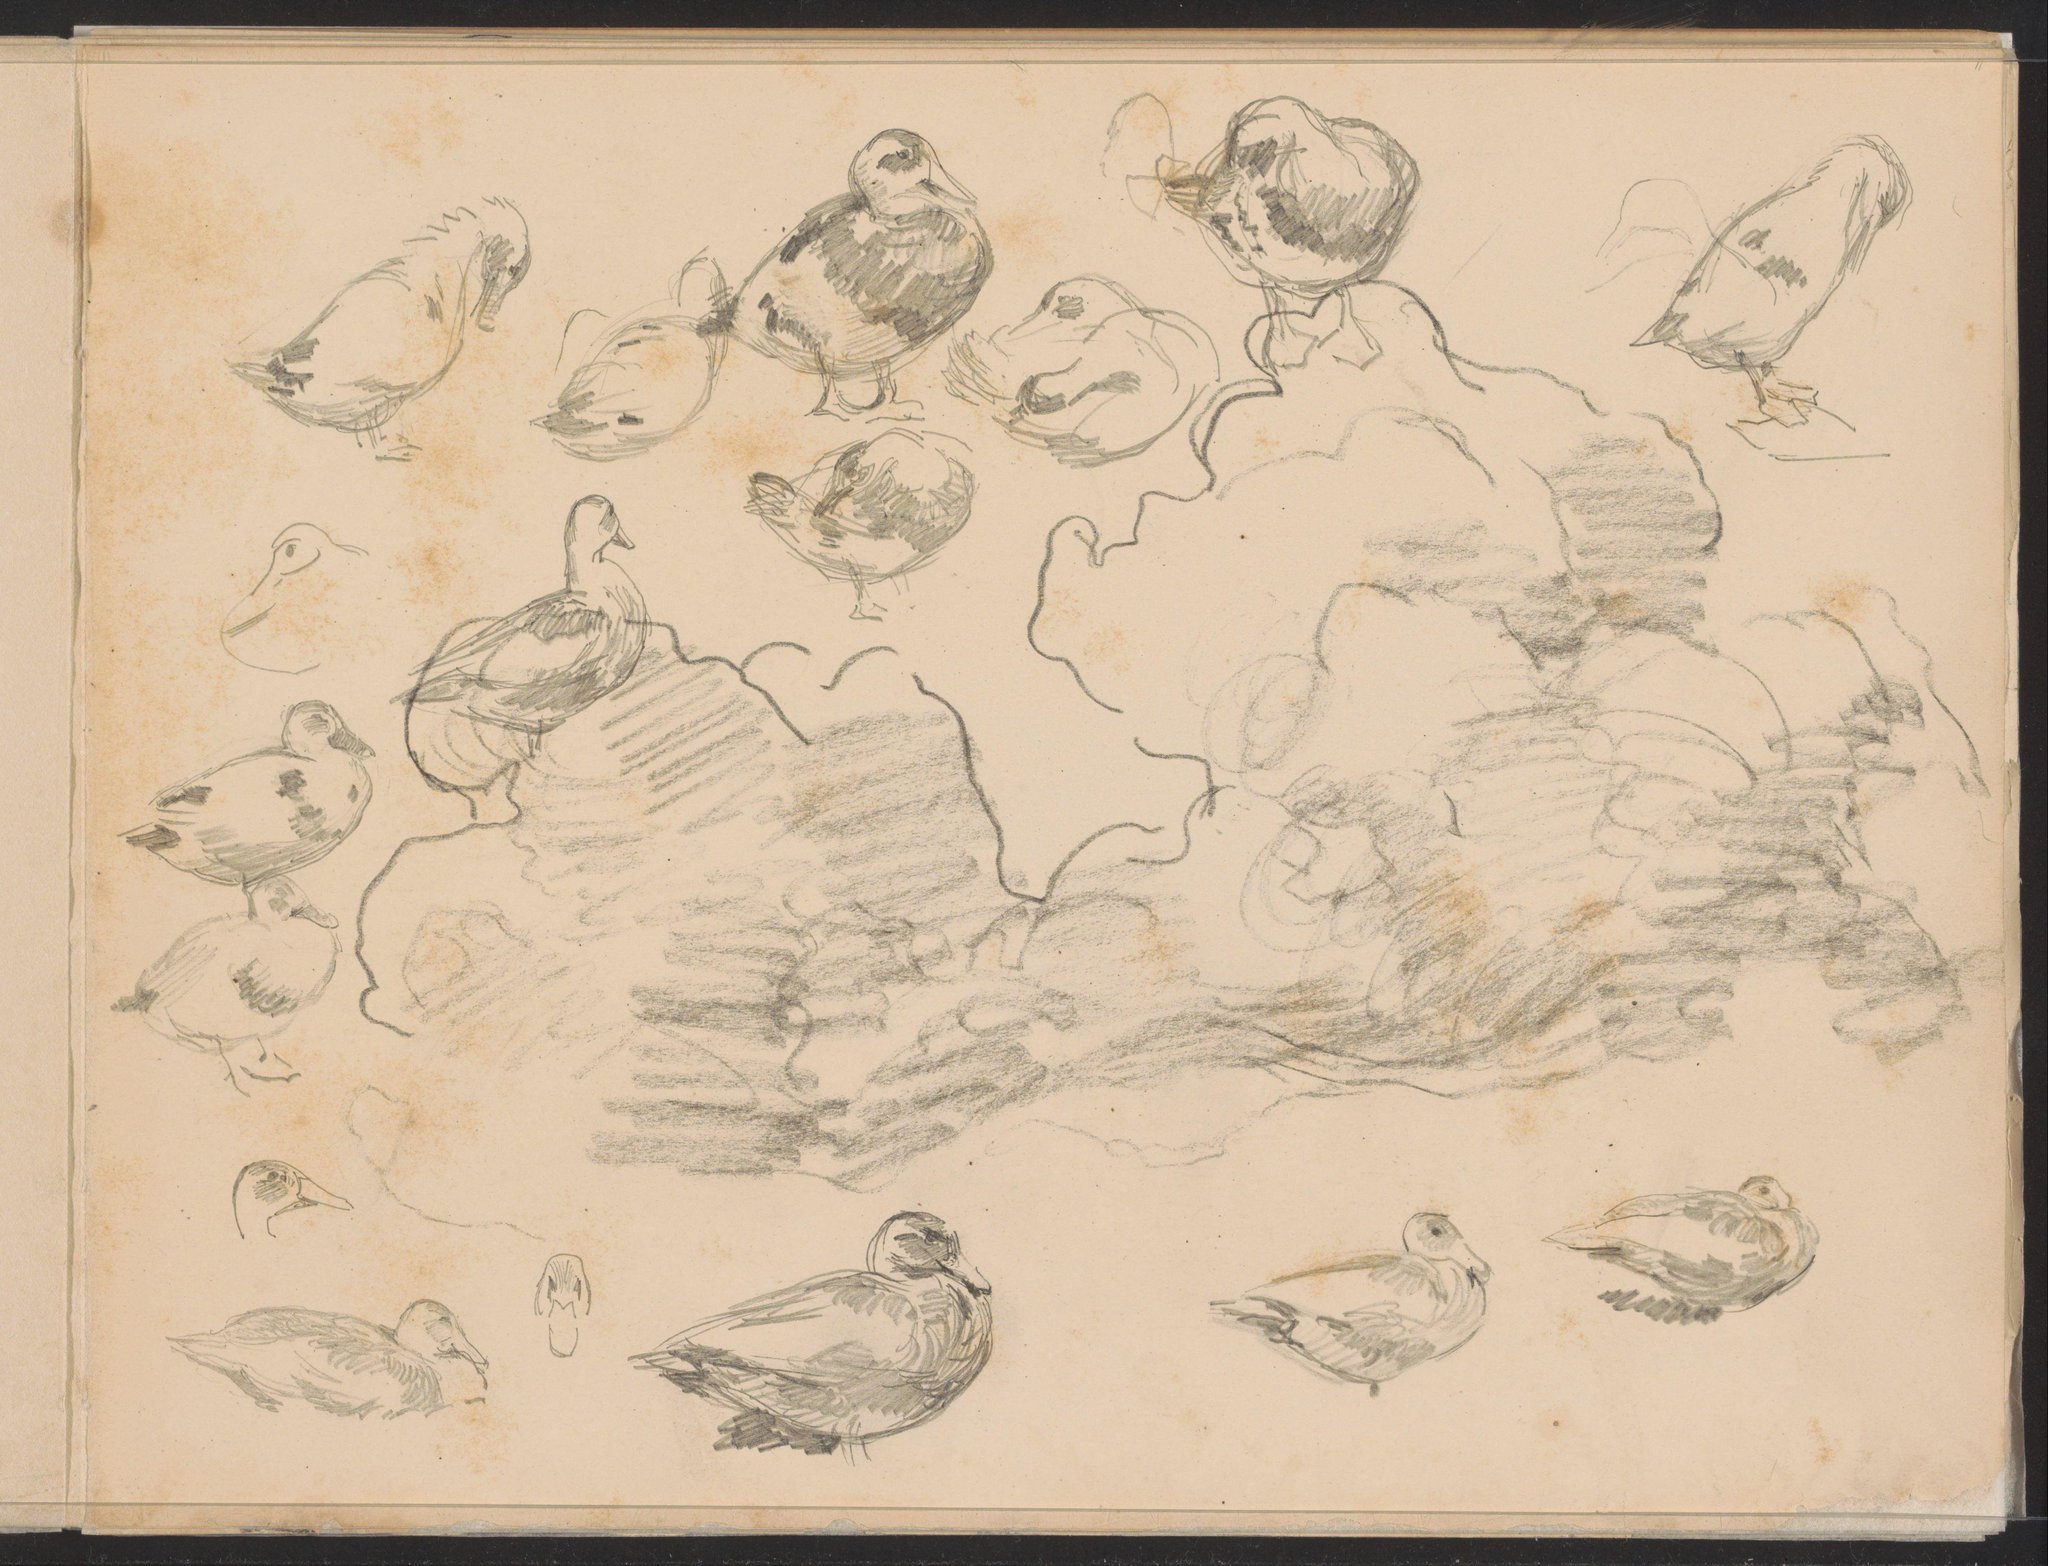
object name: sketchbook leaf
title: Wolken en eenden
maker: willem bastiaan tholen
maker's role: draughtsman, painter, print maker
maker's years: 1860-1931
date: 1870-1931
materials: chalk, paper, pencil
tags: clouds, water-birds: duck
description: Blad 11 recto uit een schetsboek met 28 bladen.